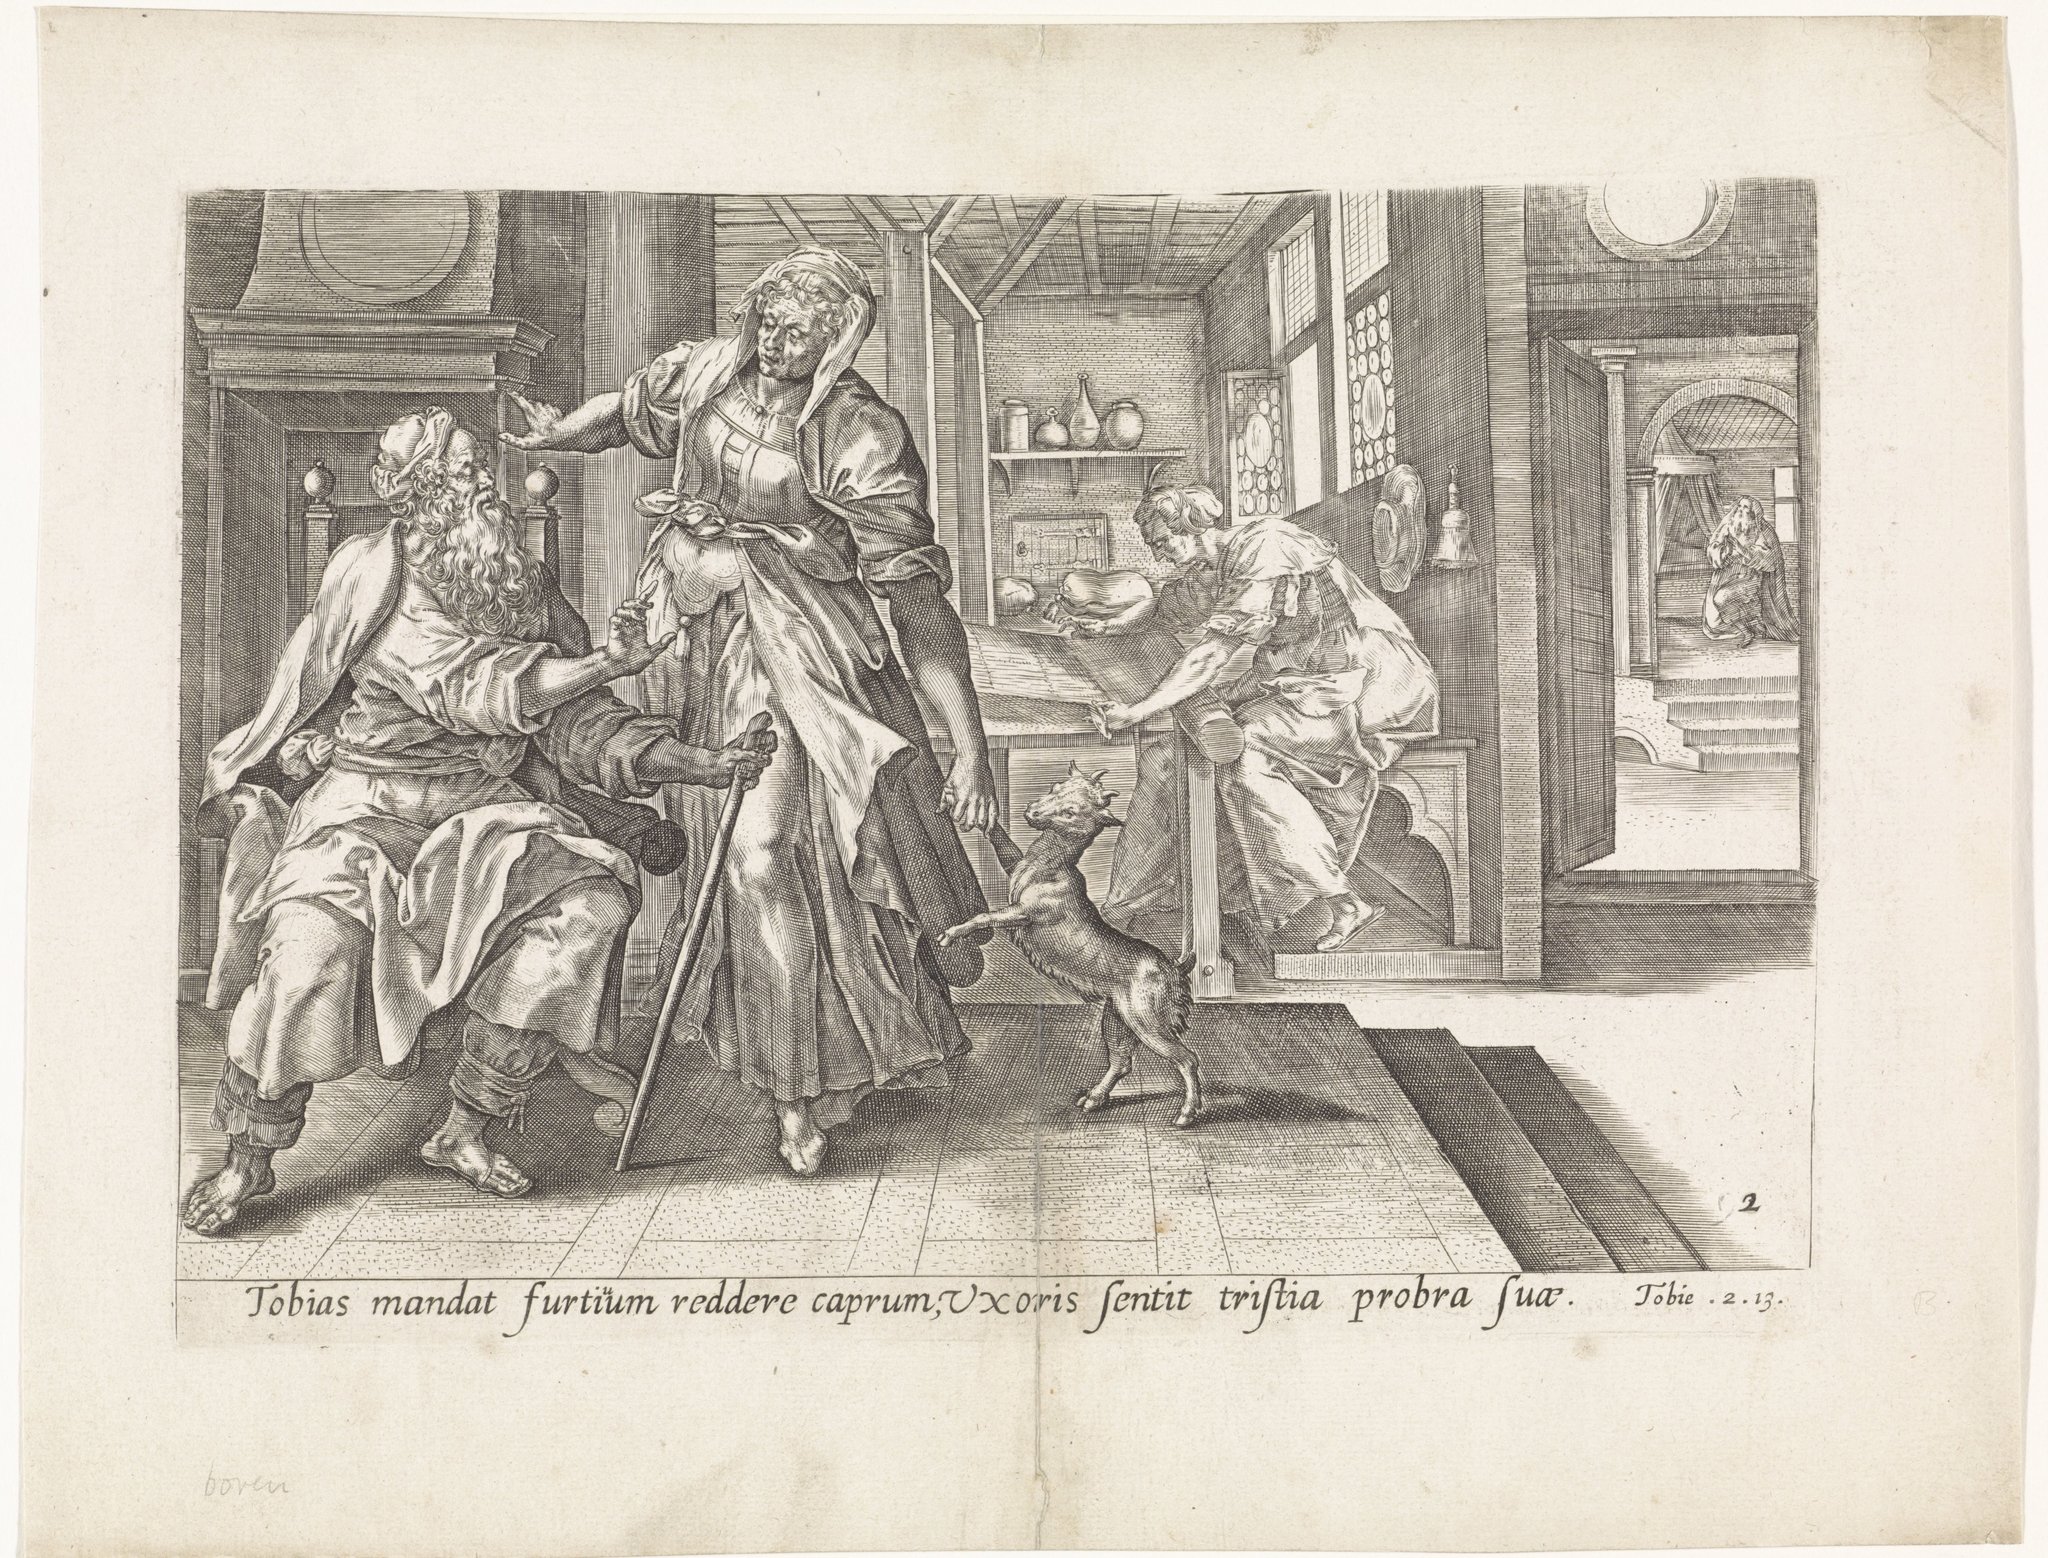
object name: print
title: Tobit en Anna met het geitje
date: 1585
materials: paper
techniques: engraving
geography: amsterdam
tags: the prayer of tobit, anna brings home a young goat: tobit thinks she has stolen it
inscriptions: collector's mark: Lugt 2228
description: Op de achtergrond verdient Anna haar geld met spinnen en weven voor haar opdrachtgevers. Naast haar loon krijgt ze als beloning een jong geitje mee naar huis. Anna staat met het geitje onder de arm voor haar blinde man Tobit, die denkt dat zij het heeft gestolen. Rechts op de achtergrond bidt Tobit tot God. Onder de voorstelling een verwijzing in het Latijn naar de Bijbeltekst in Tobit. 2.